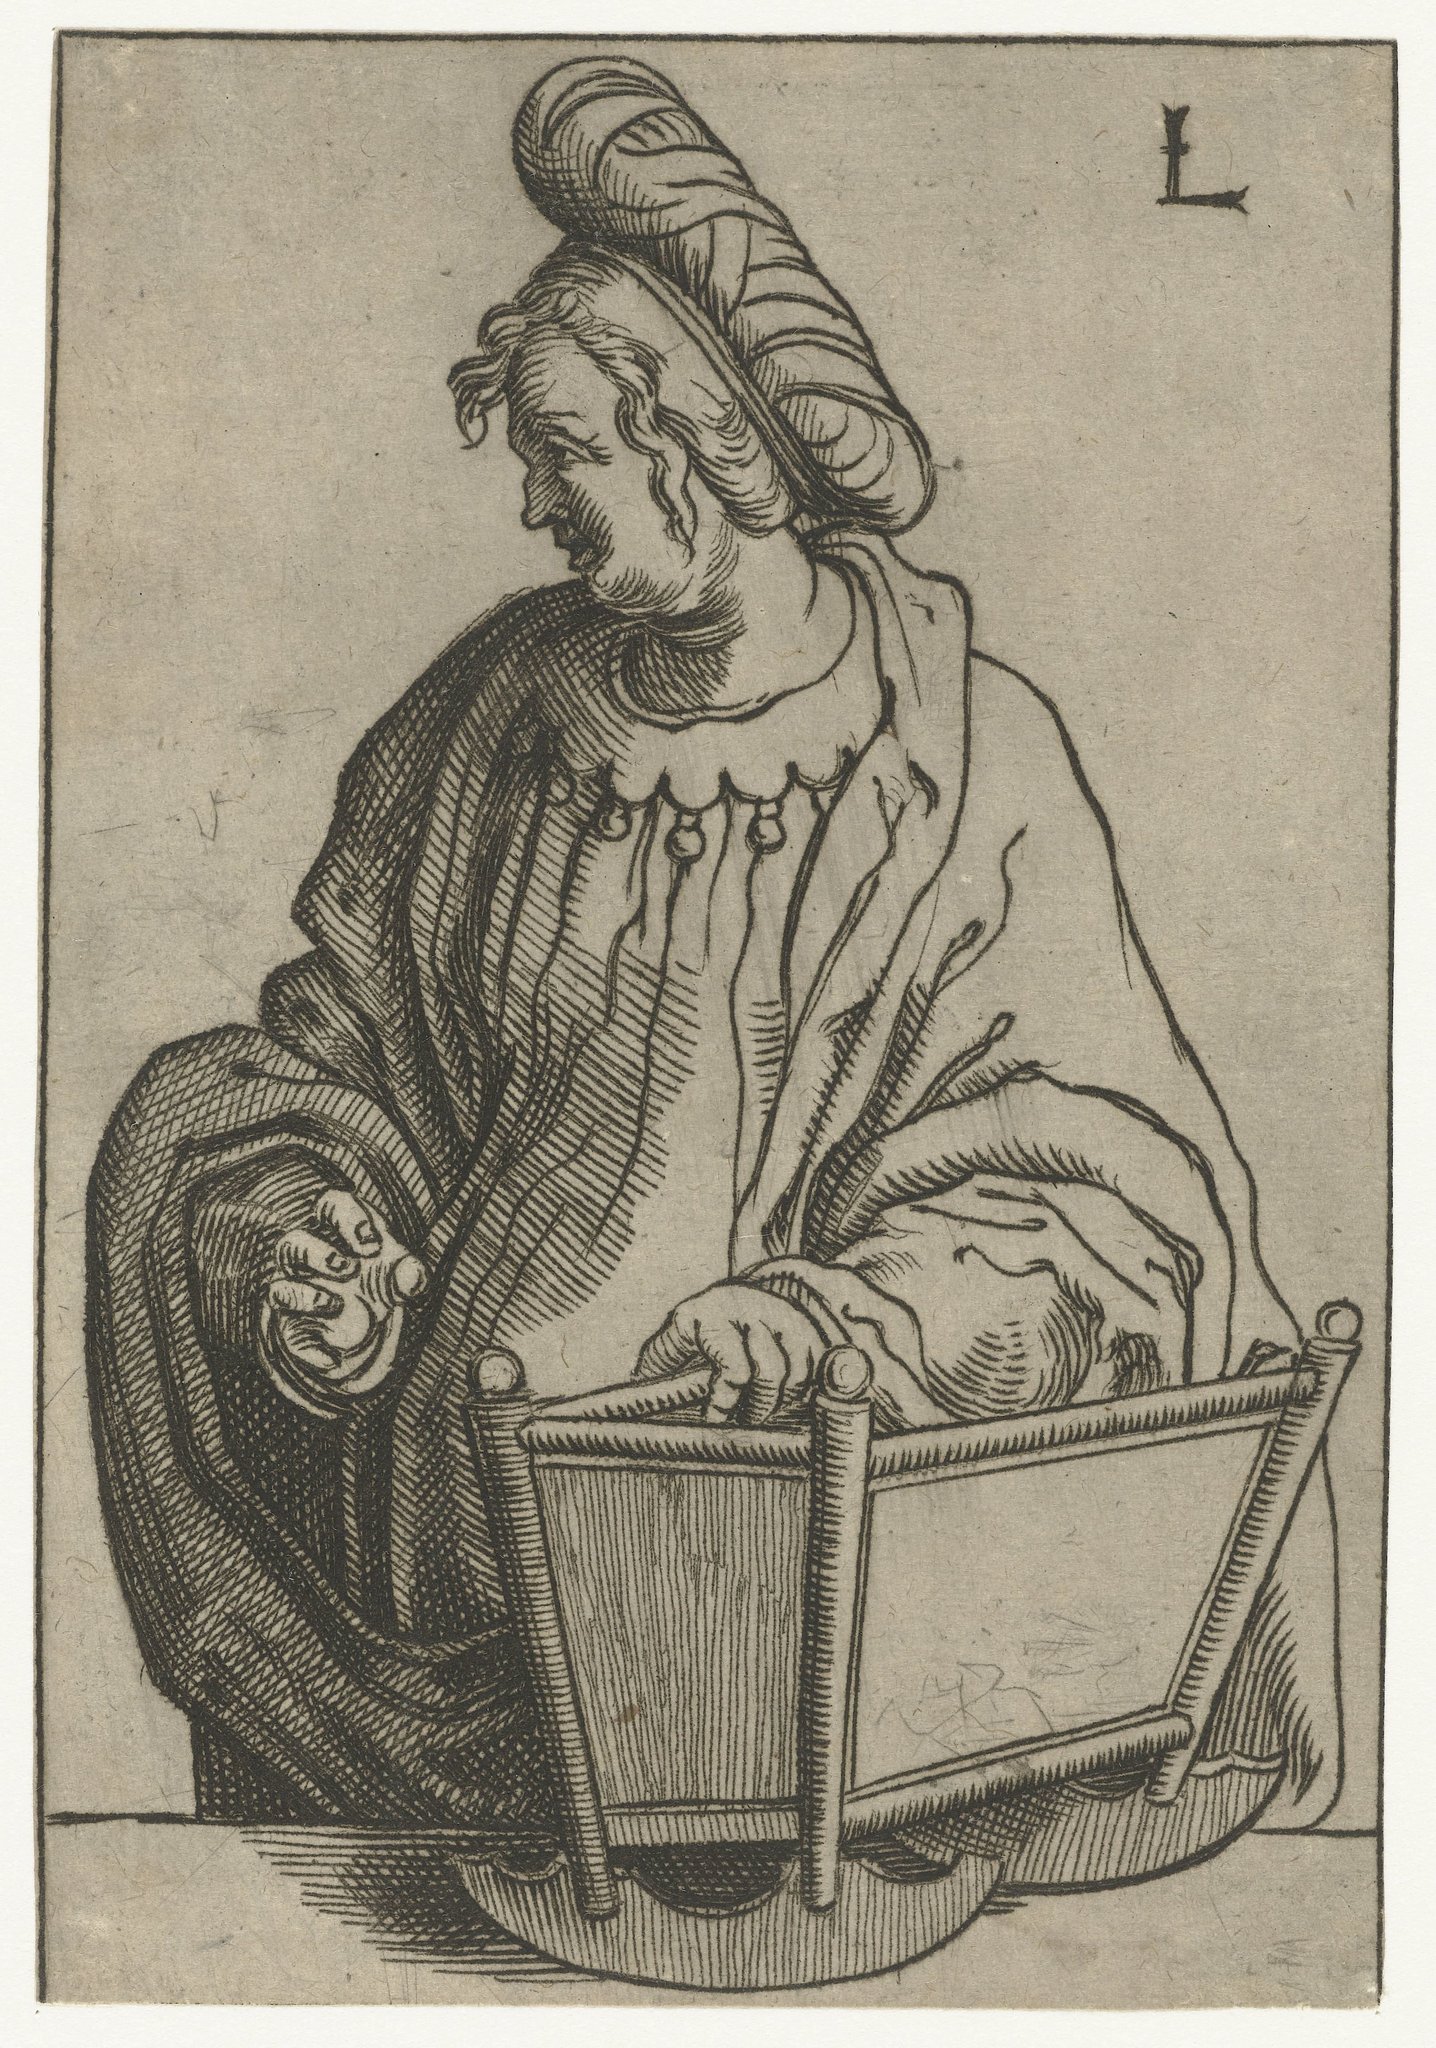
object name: print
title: De sibylle van Samos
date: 1528-1583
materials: paper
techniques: engraving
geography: low countries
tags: samian sibyl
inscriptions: collector's mark: Lugt 240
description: Kopie van houtsnede, in spiegelbeeld. Sibylle van het orakel op het eiland Samos, met wieg.